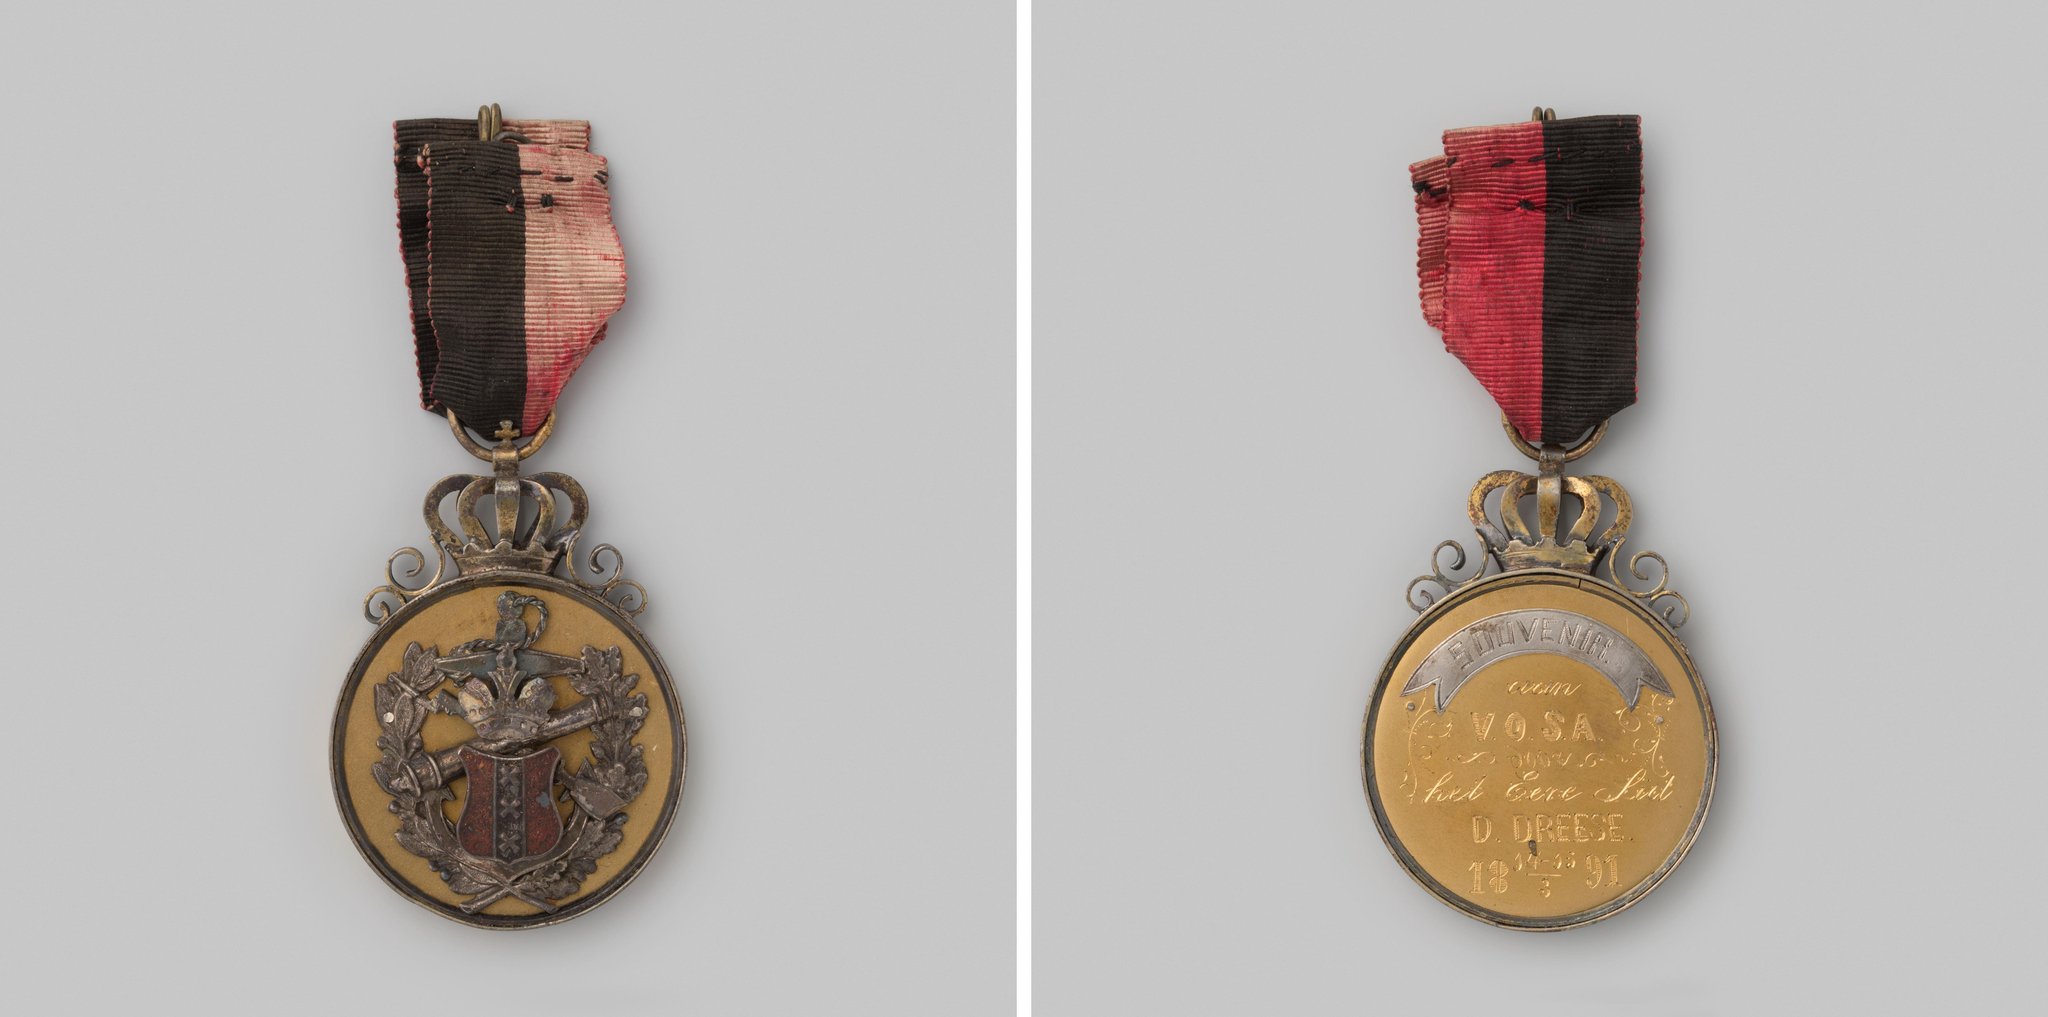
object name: history medal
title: Herinneringspenning ter gelegenheid van de nationale wedstrijd op 14 en 15 maart, uitgeschreven door de onderlinge Amsterdamse schermcursus en uitgereikt aan de vereniging van onderofficieren van de schutterij te Amsterdam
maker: Anonymous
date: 1891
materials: silver, textile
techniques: gilding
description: Verguld zilveren penning met kroon, oog, ring en lint.